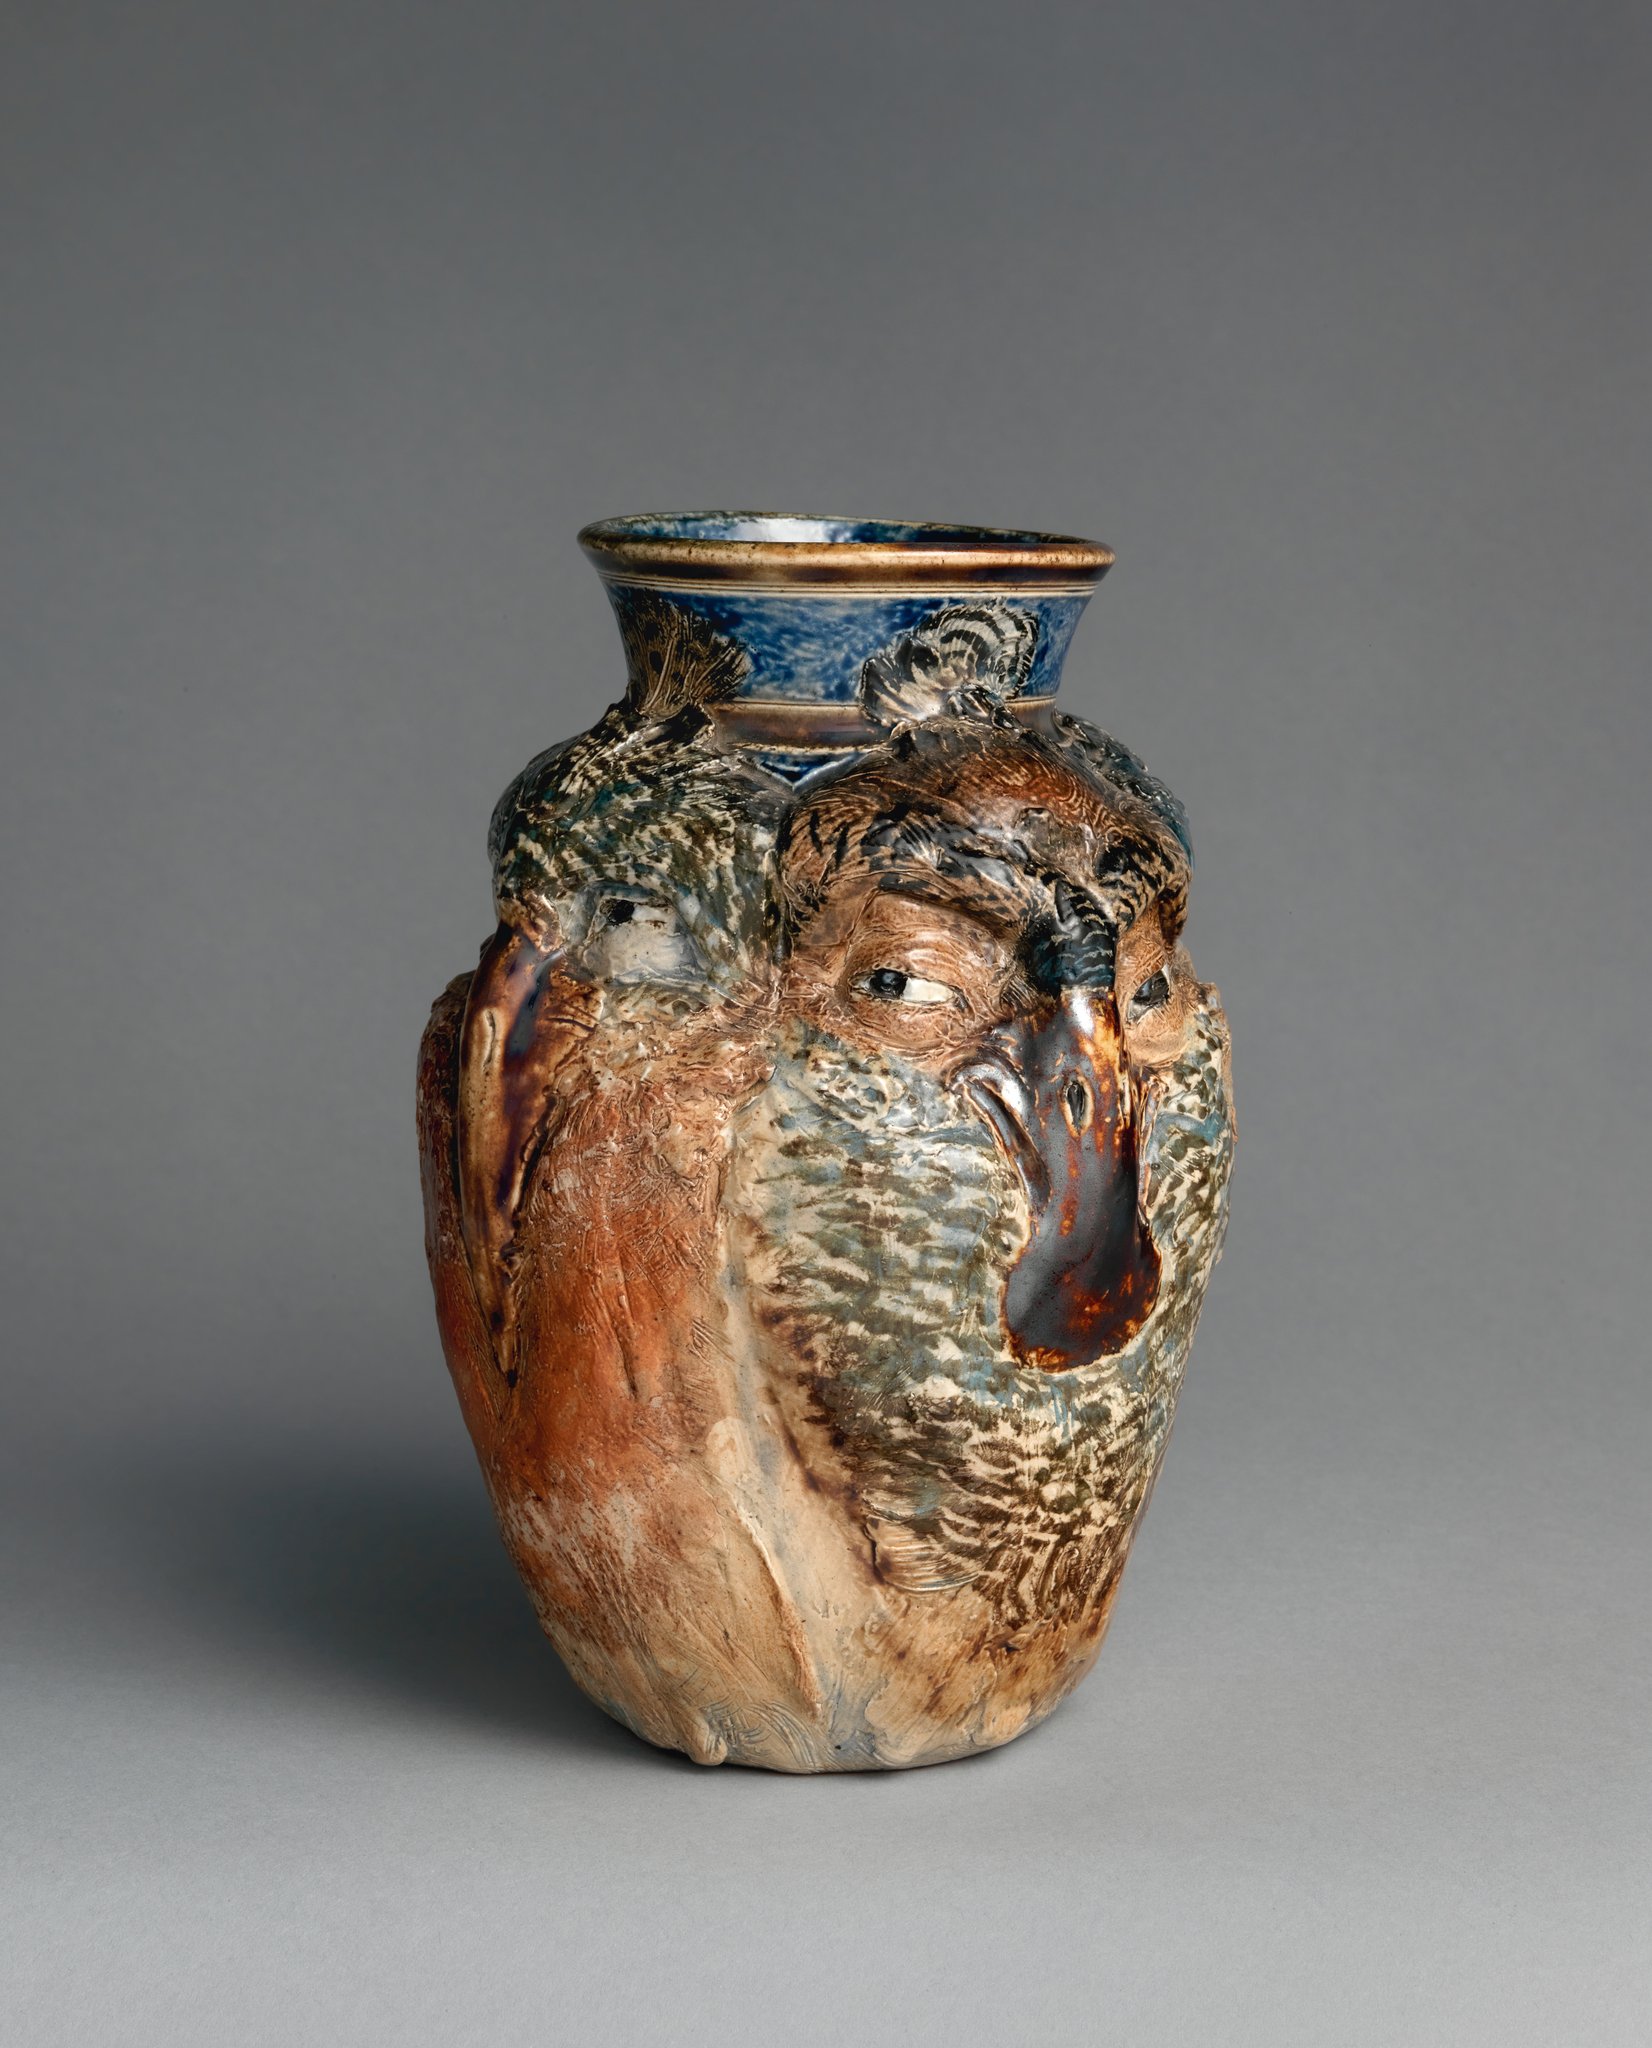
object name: jar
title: Jar with four birds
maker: r. w. martin and brothers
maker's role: maker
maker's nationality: british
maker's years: 1873-1915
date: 1892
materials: stoneware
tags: birds